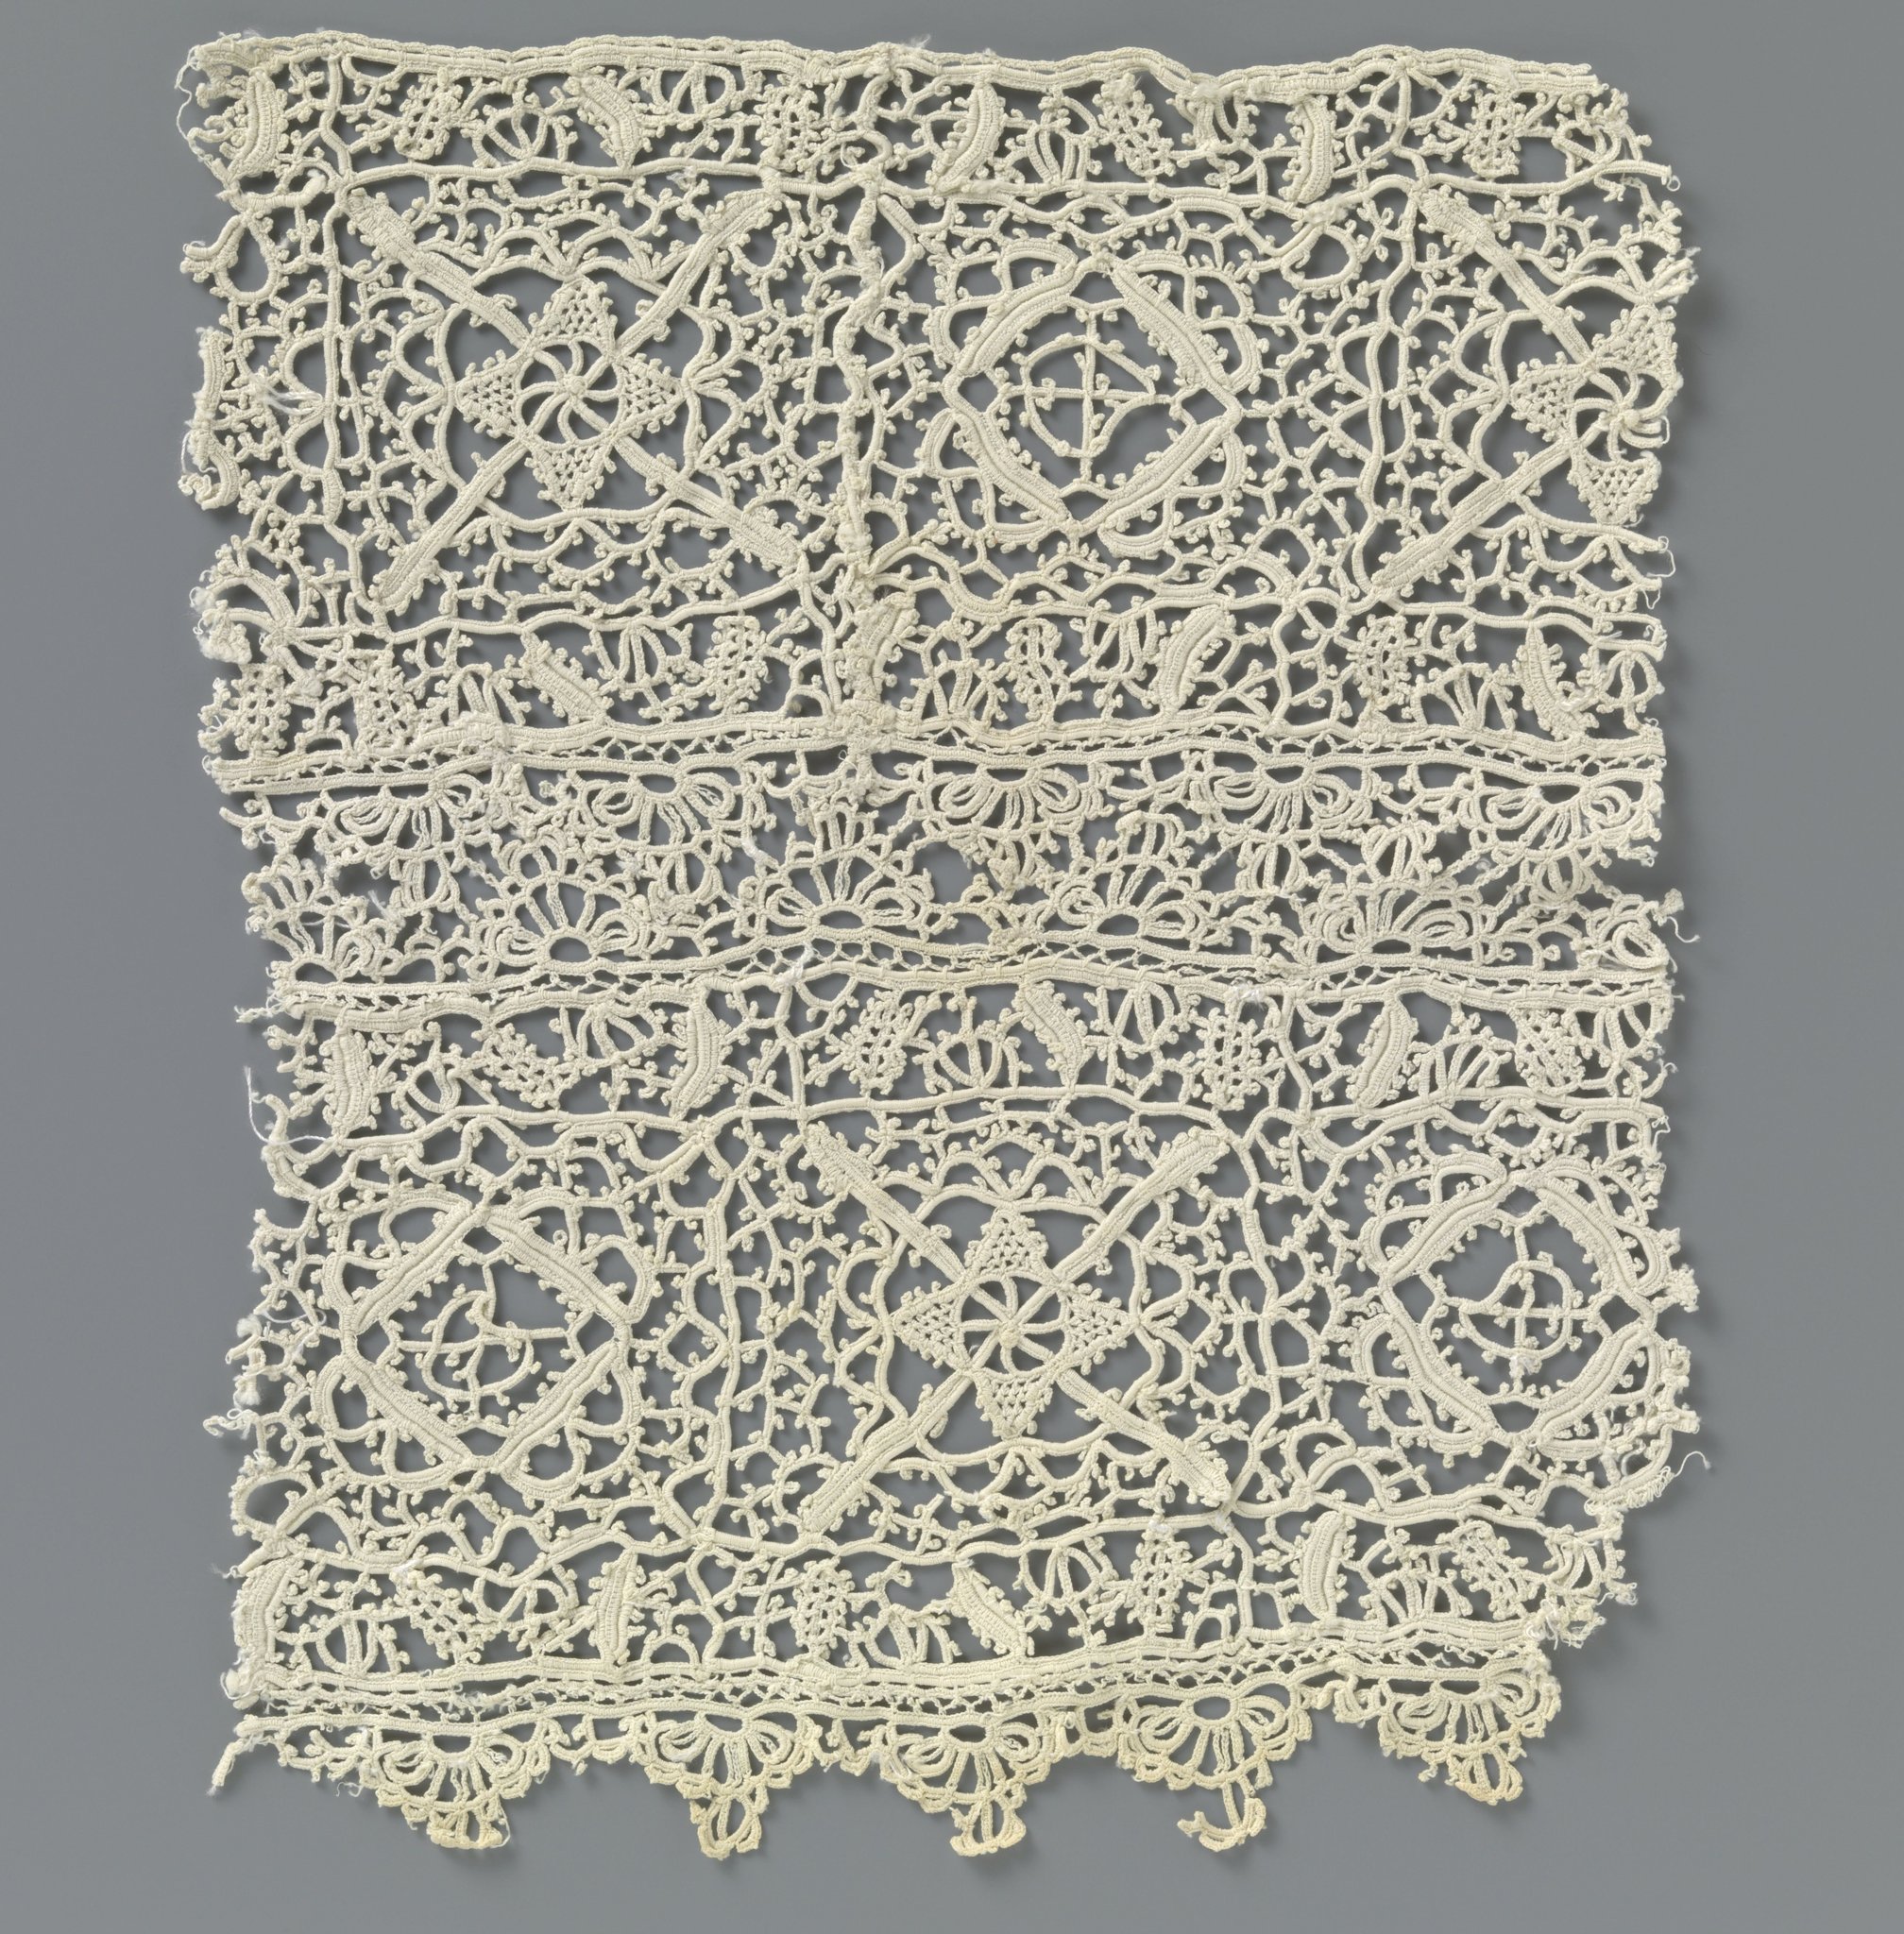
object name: strip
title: Strook gehaakte kant met reticella motieven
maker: Anonymous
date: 1890-1909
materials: cotton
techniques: crocheted lace, irish crochet lace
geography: ireland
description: Het is een aanname dat deze Ierse gehaakte kant ook daadwerkelijk in Ierland is gemaakt. Ierse gehaakte kant kent zijn oorsprong rond 1760 en kwam vanaf 1840 in ontwikkeling. Aangezien volgens Martine Bruggeman (Kant in Europa) de Ierse haakindustrie aan het eind van de 19e eeuw gereorganiseerd werd en in populariteit groeide, is het hier beschreven stuk gedateerd rond 1890, tot 1909 vanwege de datering in het eerste decennium van populariteit van Ierse gehaakte kant volgens het Kantlexicon (Johan Coene).